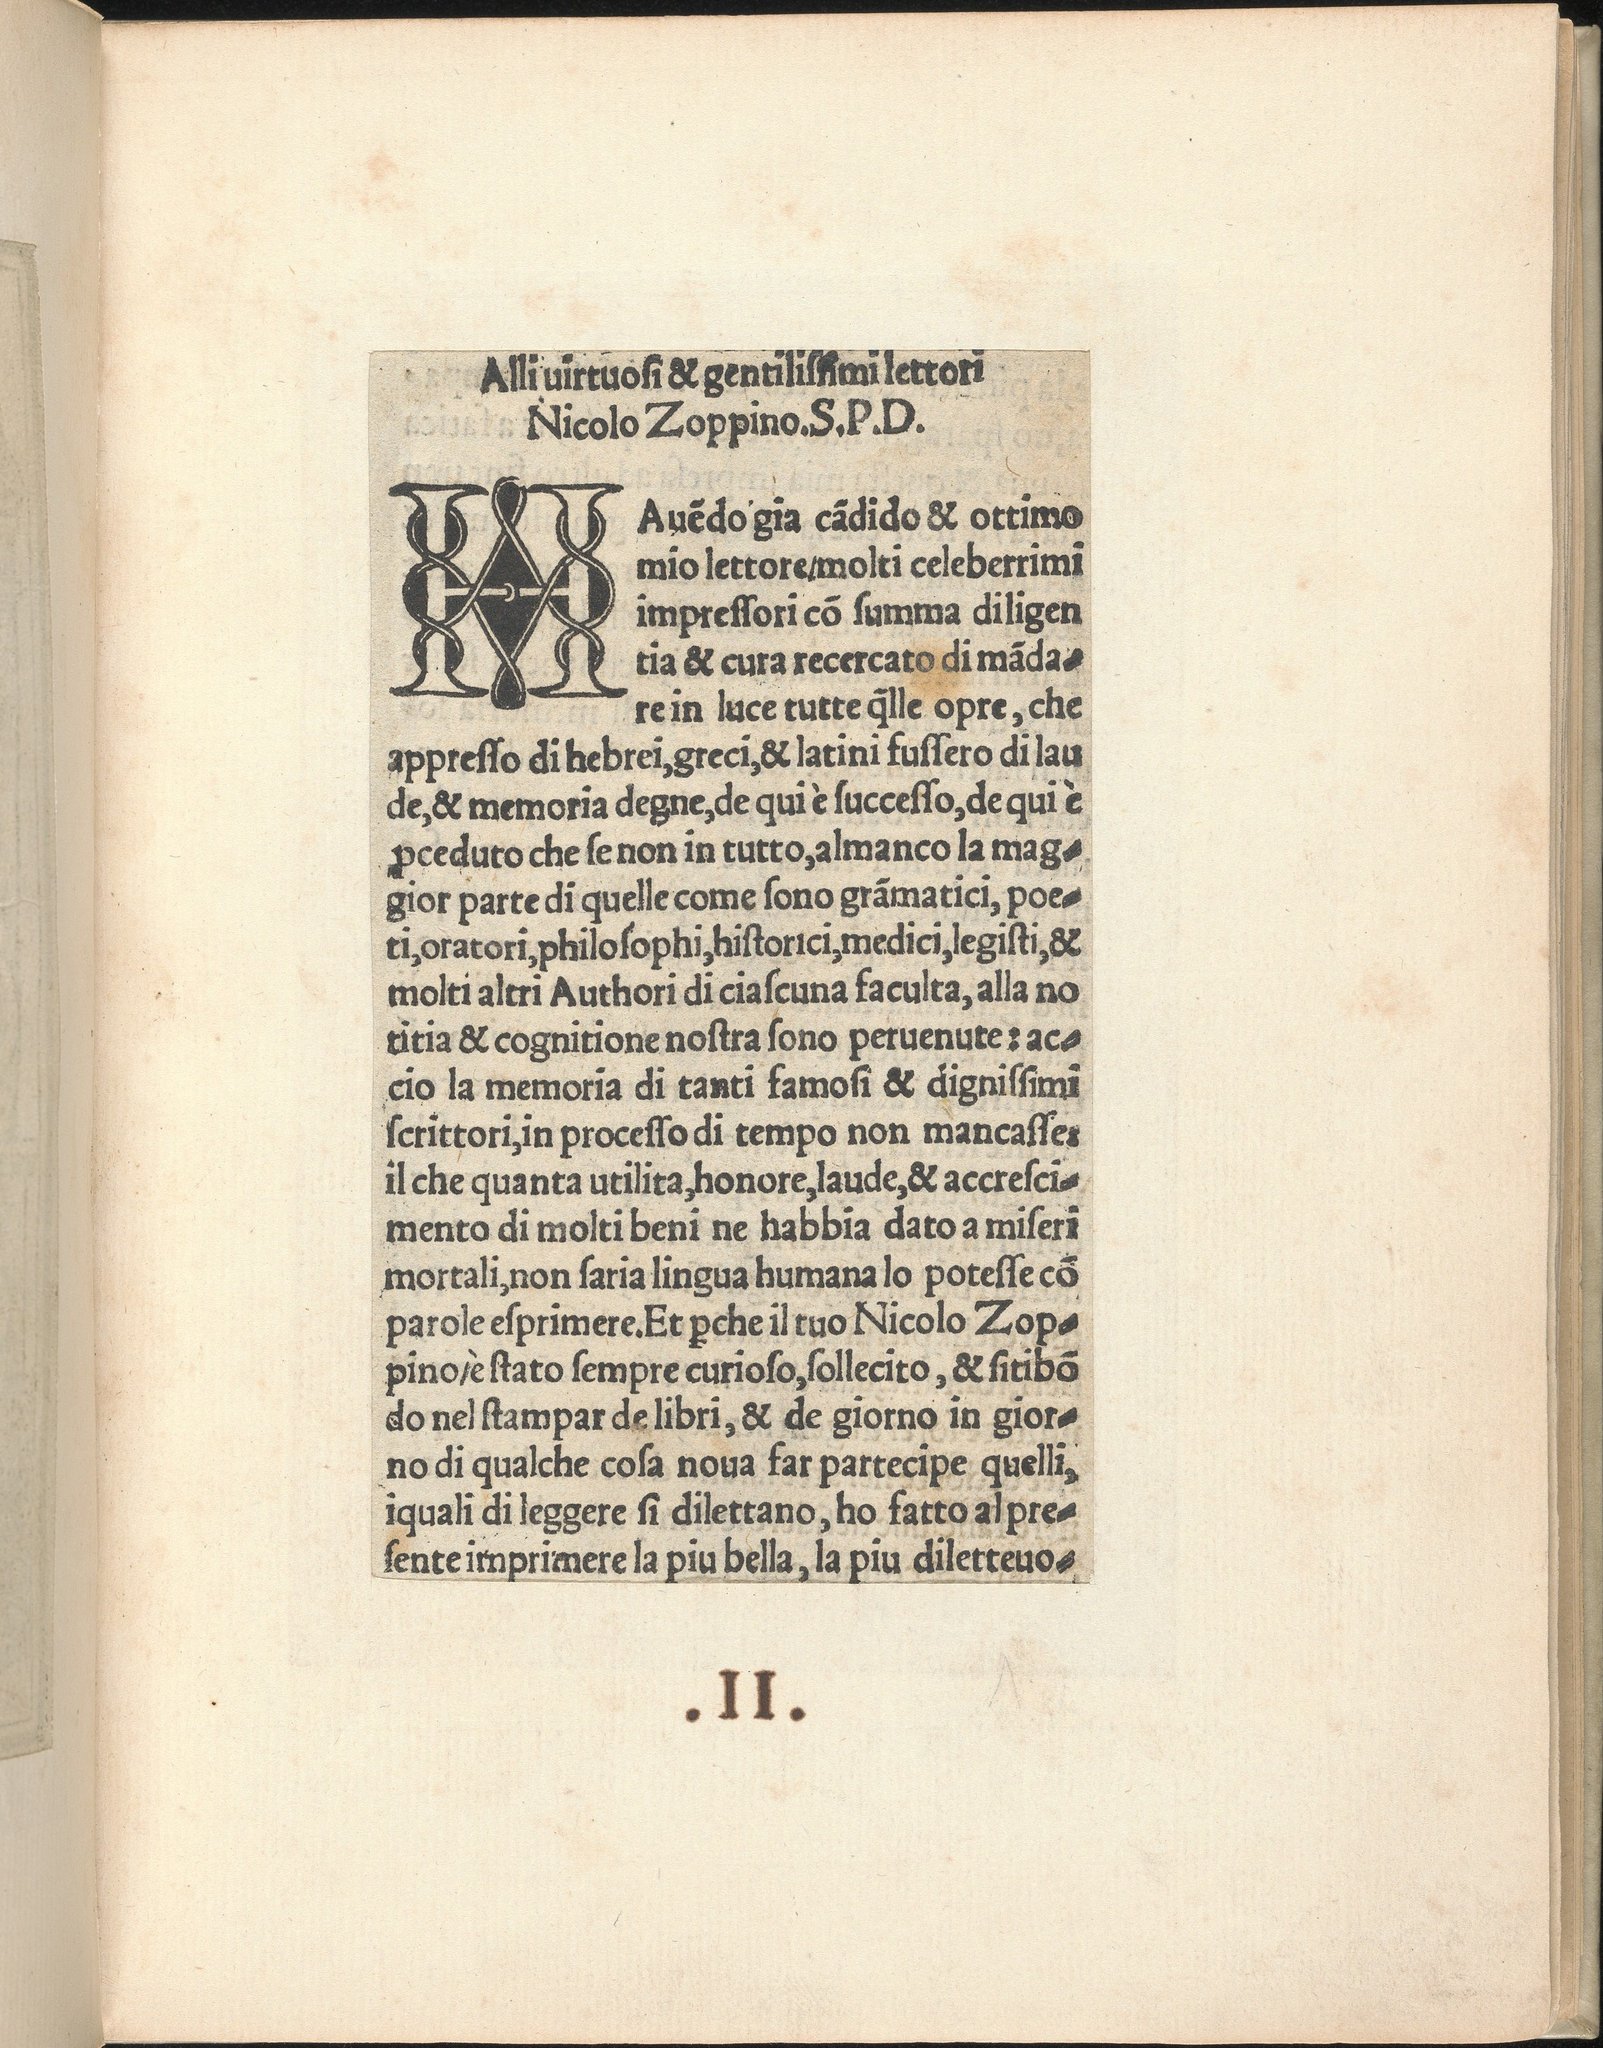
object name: book print ornament architecture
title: Esemplario di lavori, page 2 (recto)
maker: nicolò zoppino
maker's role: publisher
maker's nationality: italian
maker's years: 1478-1544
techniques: bookbinding, inlay, woodcut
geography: italy